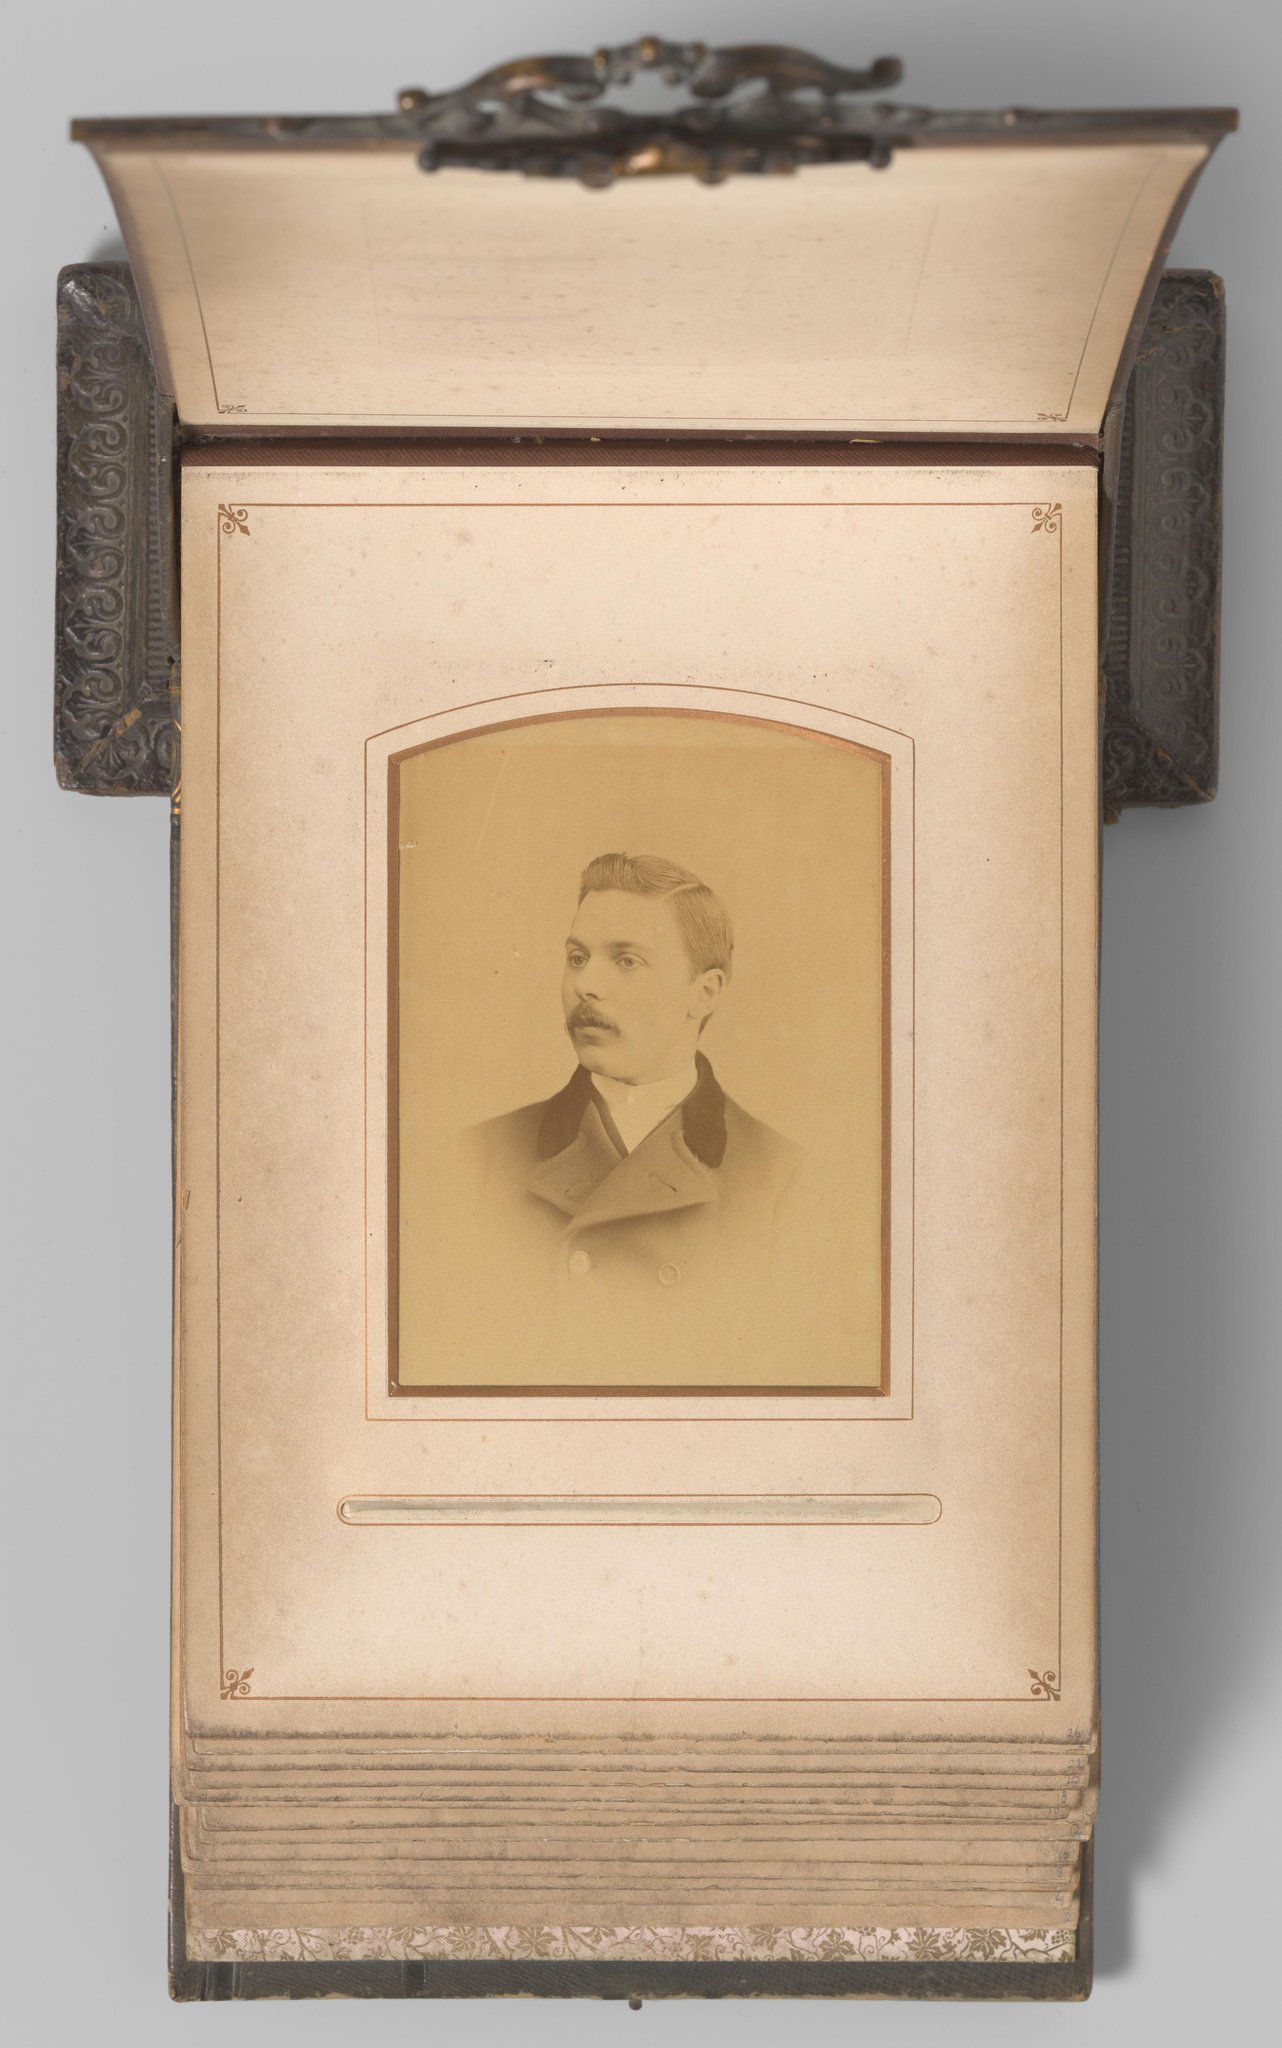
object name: photograph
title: Portret van een jonge man met snor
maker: henry thomas edwards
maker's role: fotograaf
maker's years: 1857-1935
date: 1886-1904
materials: cardboard, photographic support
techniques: albumen print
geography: brighton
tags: moustache, historical persons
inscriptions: inscription: ‘H. T. Edwards/ 11, Lewes Road/ BRIGHTON’